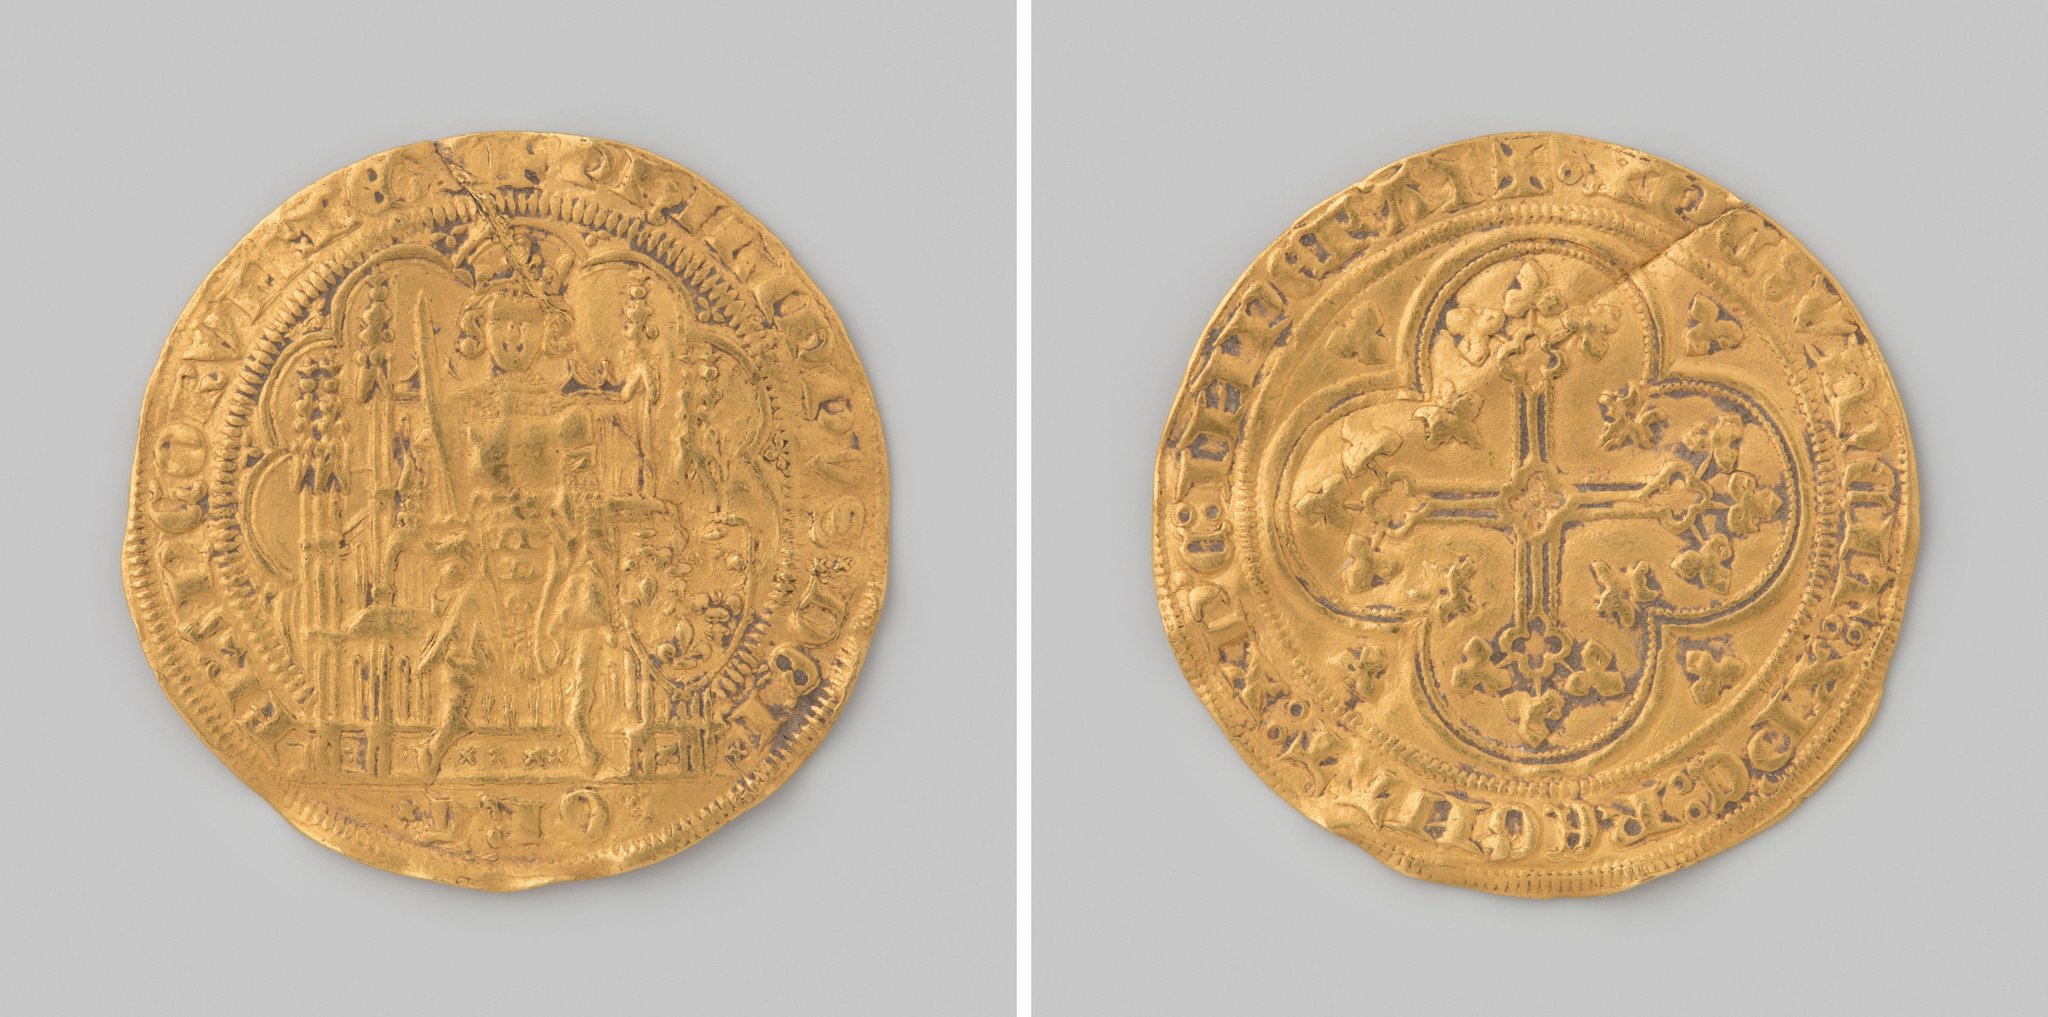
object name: coin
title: Frankrijk, gouden schild, Philips VI van Valois,1328-1350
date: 1328-1350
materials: gold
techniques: striking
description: Gouden munt. Voorzijde: binnen veelpas vorst op zetel met in de rechterhand een zwaard en met de linker een schild vasthoudend. Keerzijde: binnen dubellijnige vierpas kort versierd kruis.